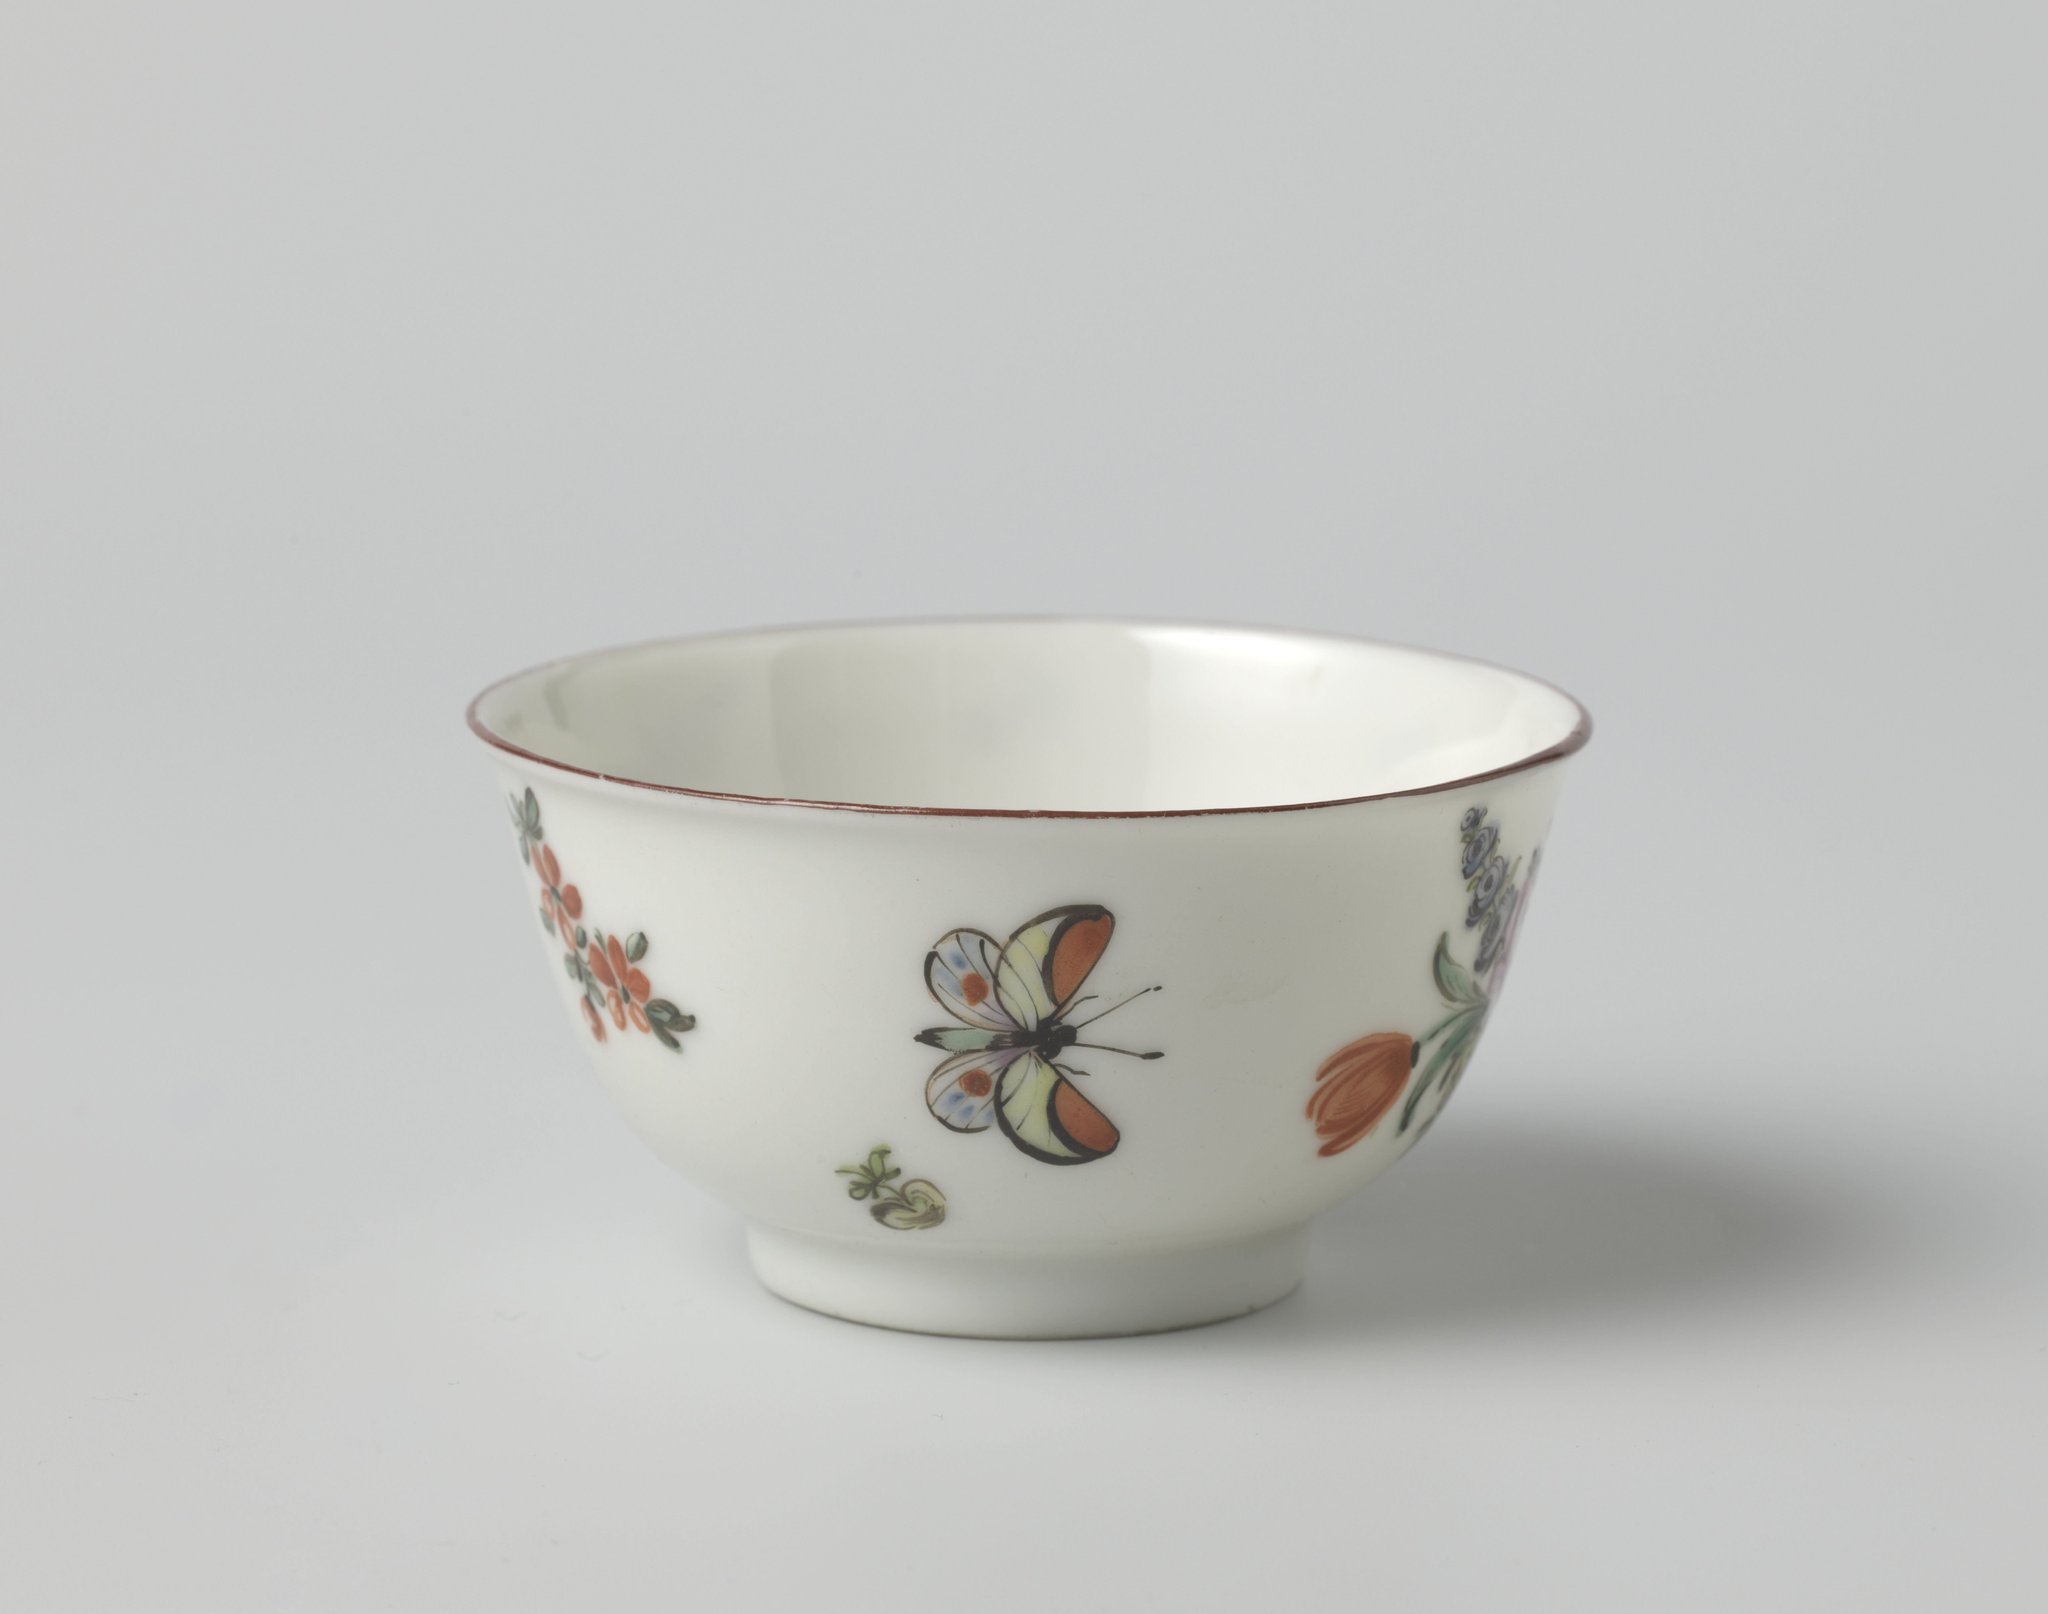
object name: cup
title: Bell-shaped cup with flower sprays and a butterfly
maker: Anonymous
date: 1790-1800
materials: glaze, paint, porcelain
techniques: firing, turning, vitrification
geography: china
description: Kop van porselein, met bijbehorende schotel (B). Met polychrome beschildering van strooiboeketten en vlinders in de kleuren rood, paars, blauw, geel, groen en zwart; de randen met bruin. Opmerking: in China gebakken en in Chelsea gedecoreerd.